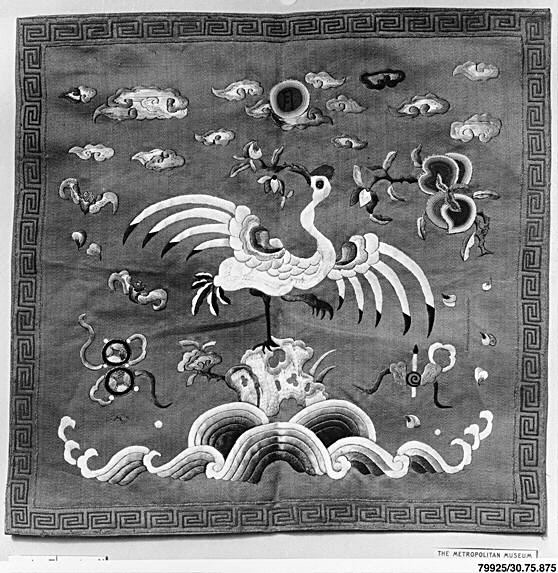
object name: rank badge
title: Rank Badge with Manchurian Crane, Wave and Cloud Motifs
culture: chinese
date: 1701-1733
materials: metal thread, silk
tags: bats,cranes